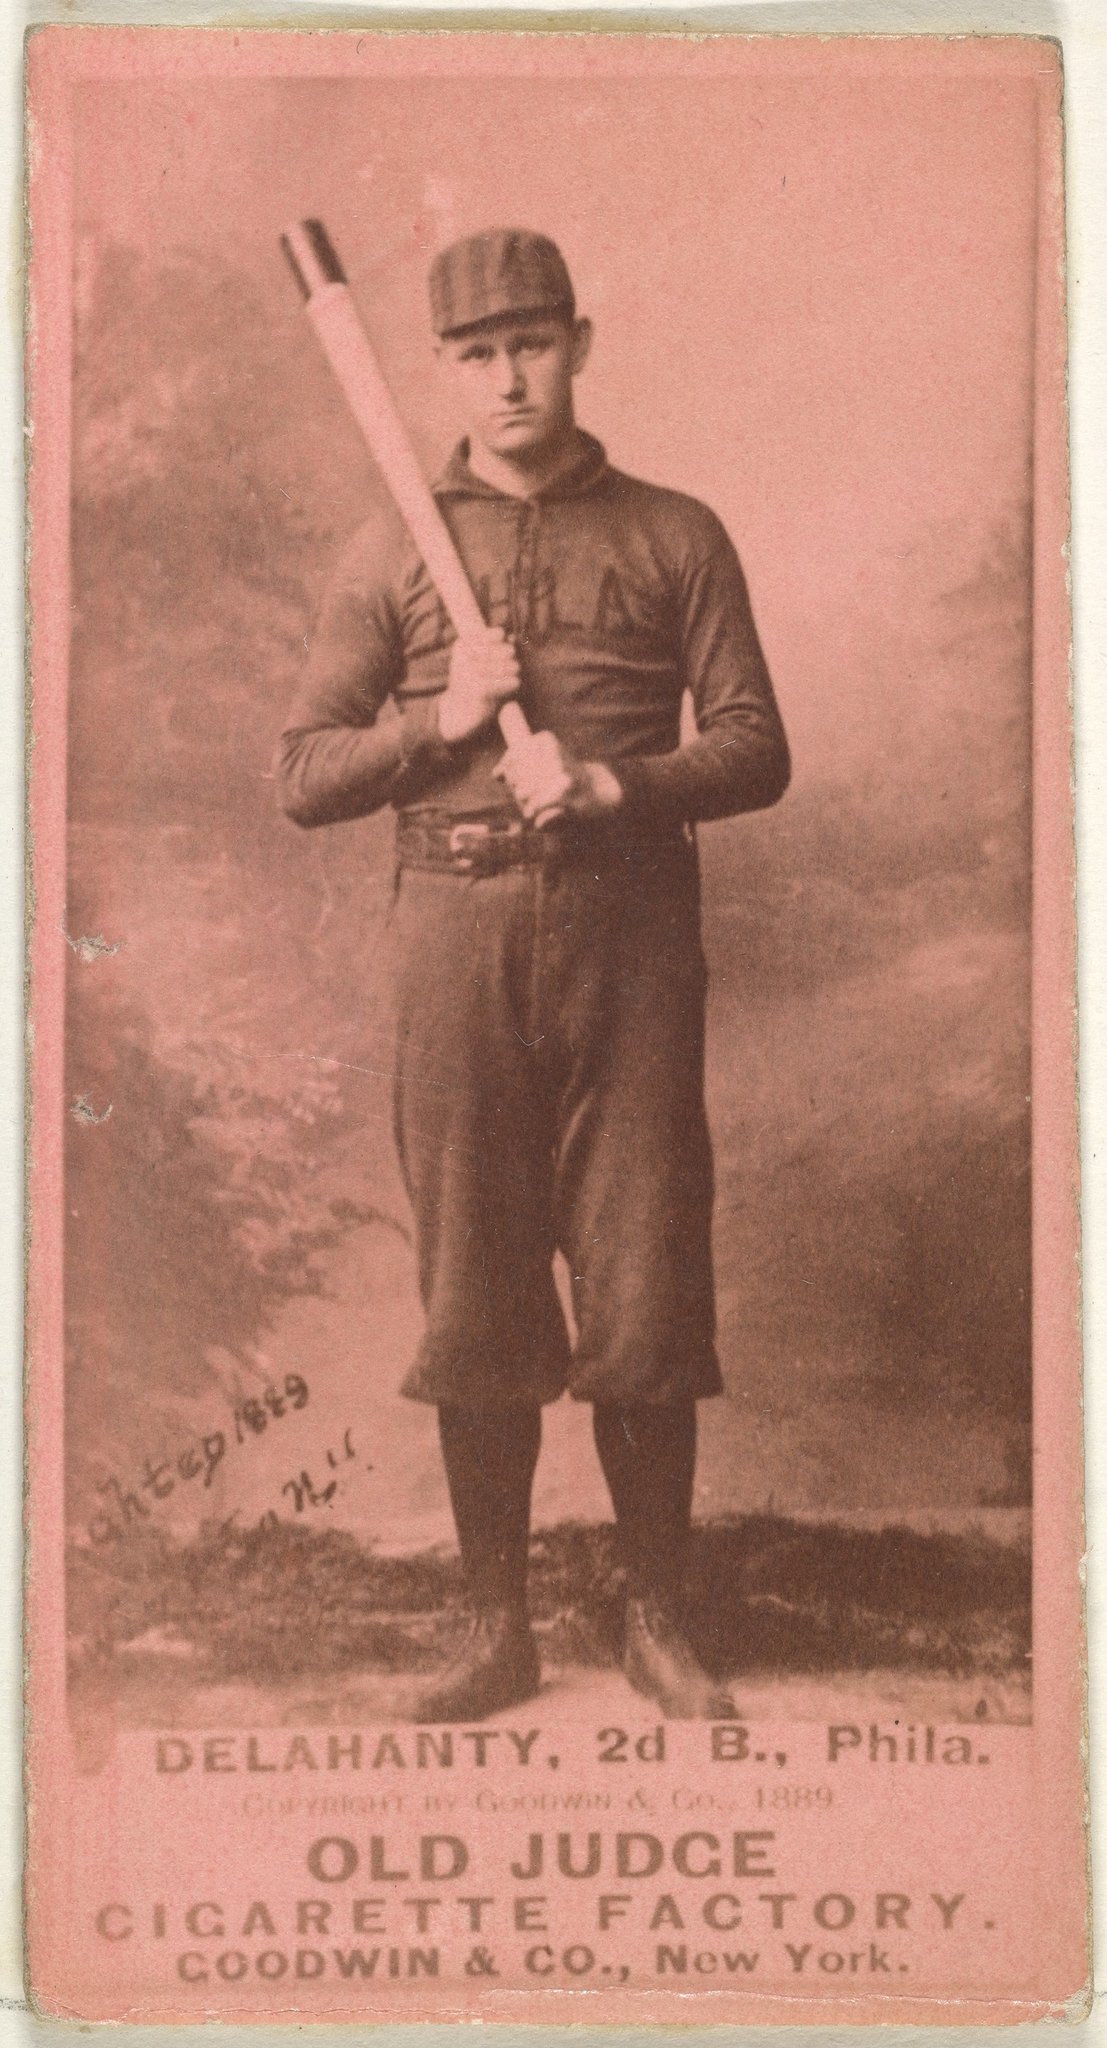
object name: baseball card, photograph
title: Edward James "Big Ed" Delahanty, 2nd Base, Philadelphia, from the Old Judge series (N172) for Old Judge Cigarettes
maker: goodwin & company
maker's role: publisher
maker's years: 1850-1950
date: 1889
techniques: albumen silver print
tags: men,portraits,baseball,athletes